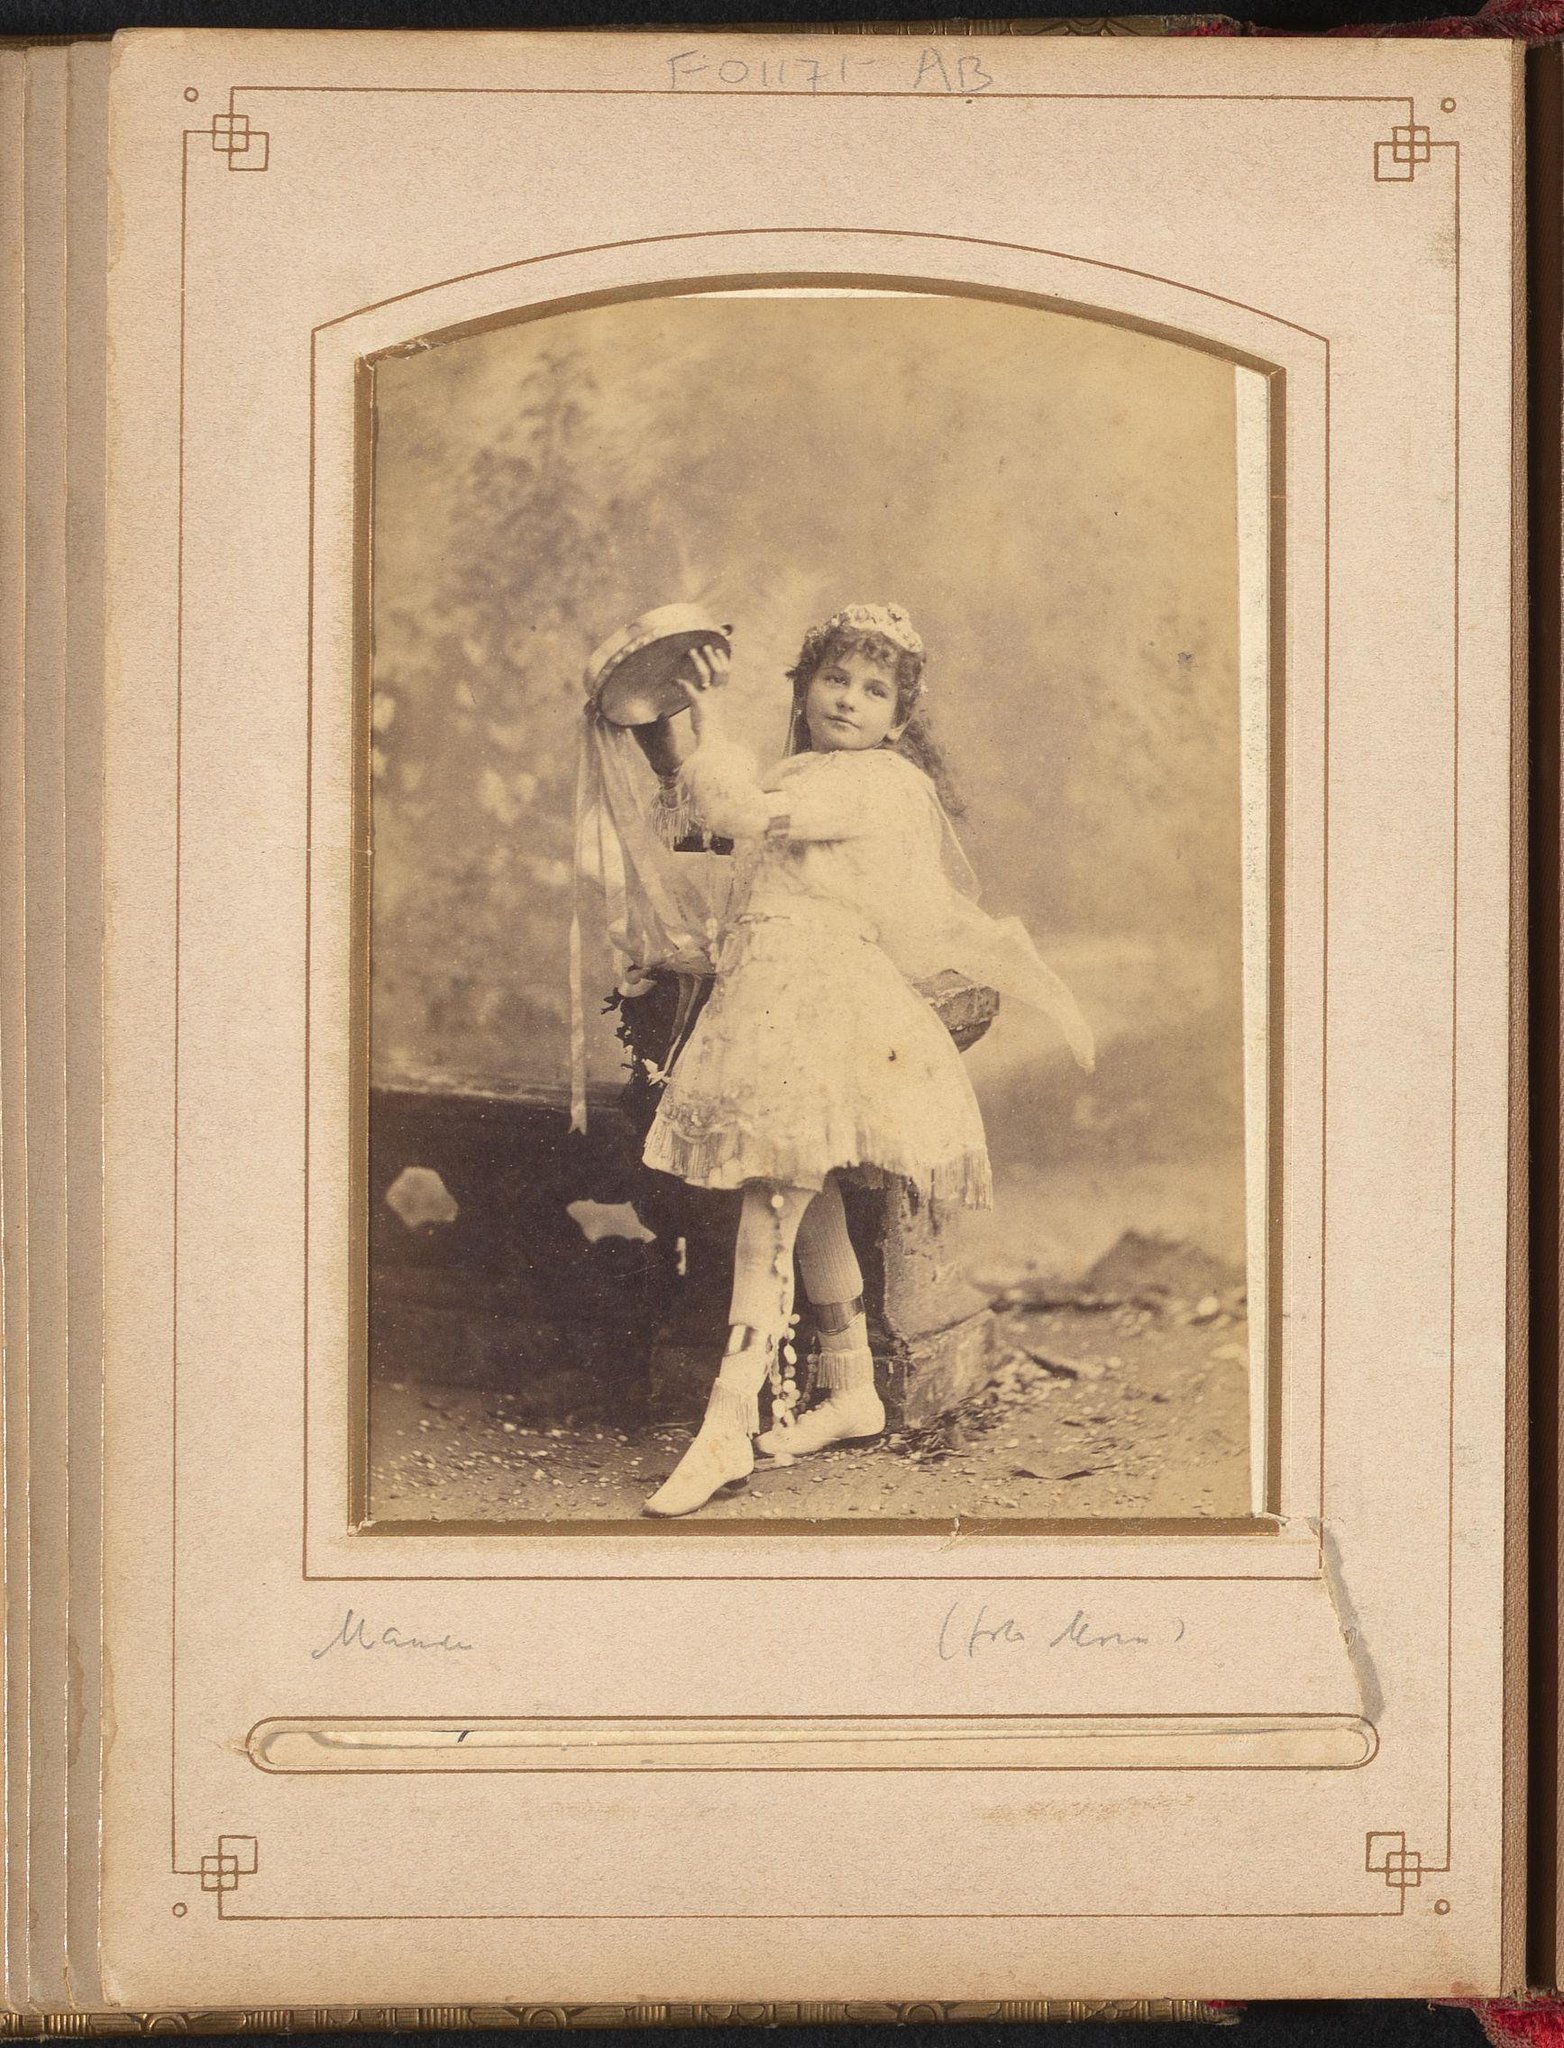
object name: cabinet photograph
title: Portret van Maude met tamboerijn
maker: josé maria mora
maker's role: fotograaf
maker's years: 1849-1926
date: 1870-1900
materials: cardboard, photographic support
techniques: albumen print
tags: tambourine, girl (child between toddler and youth)